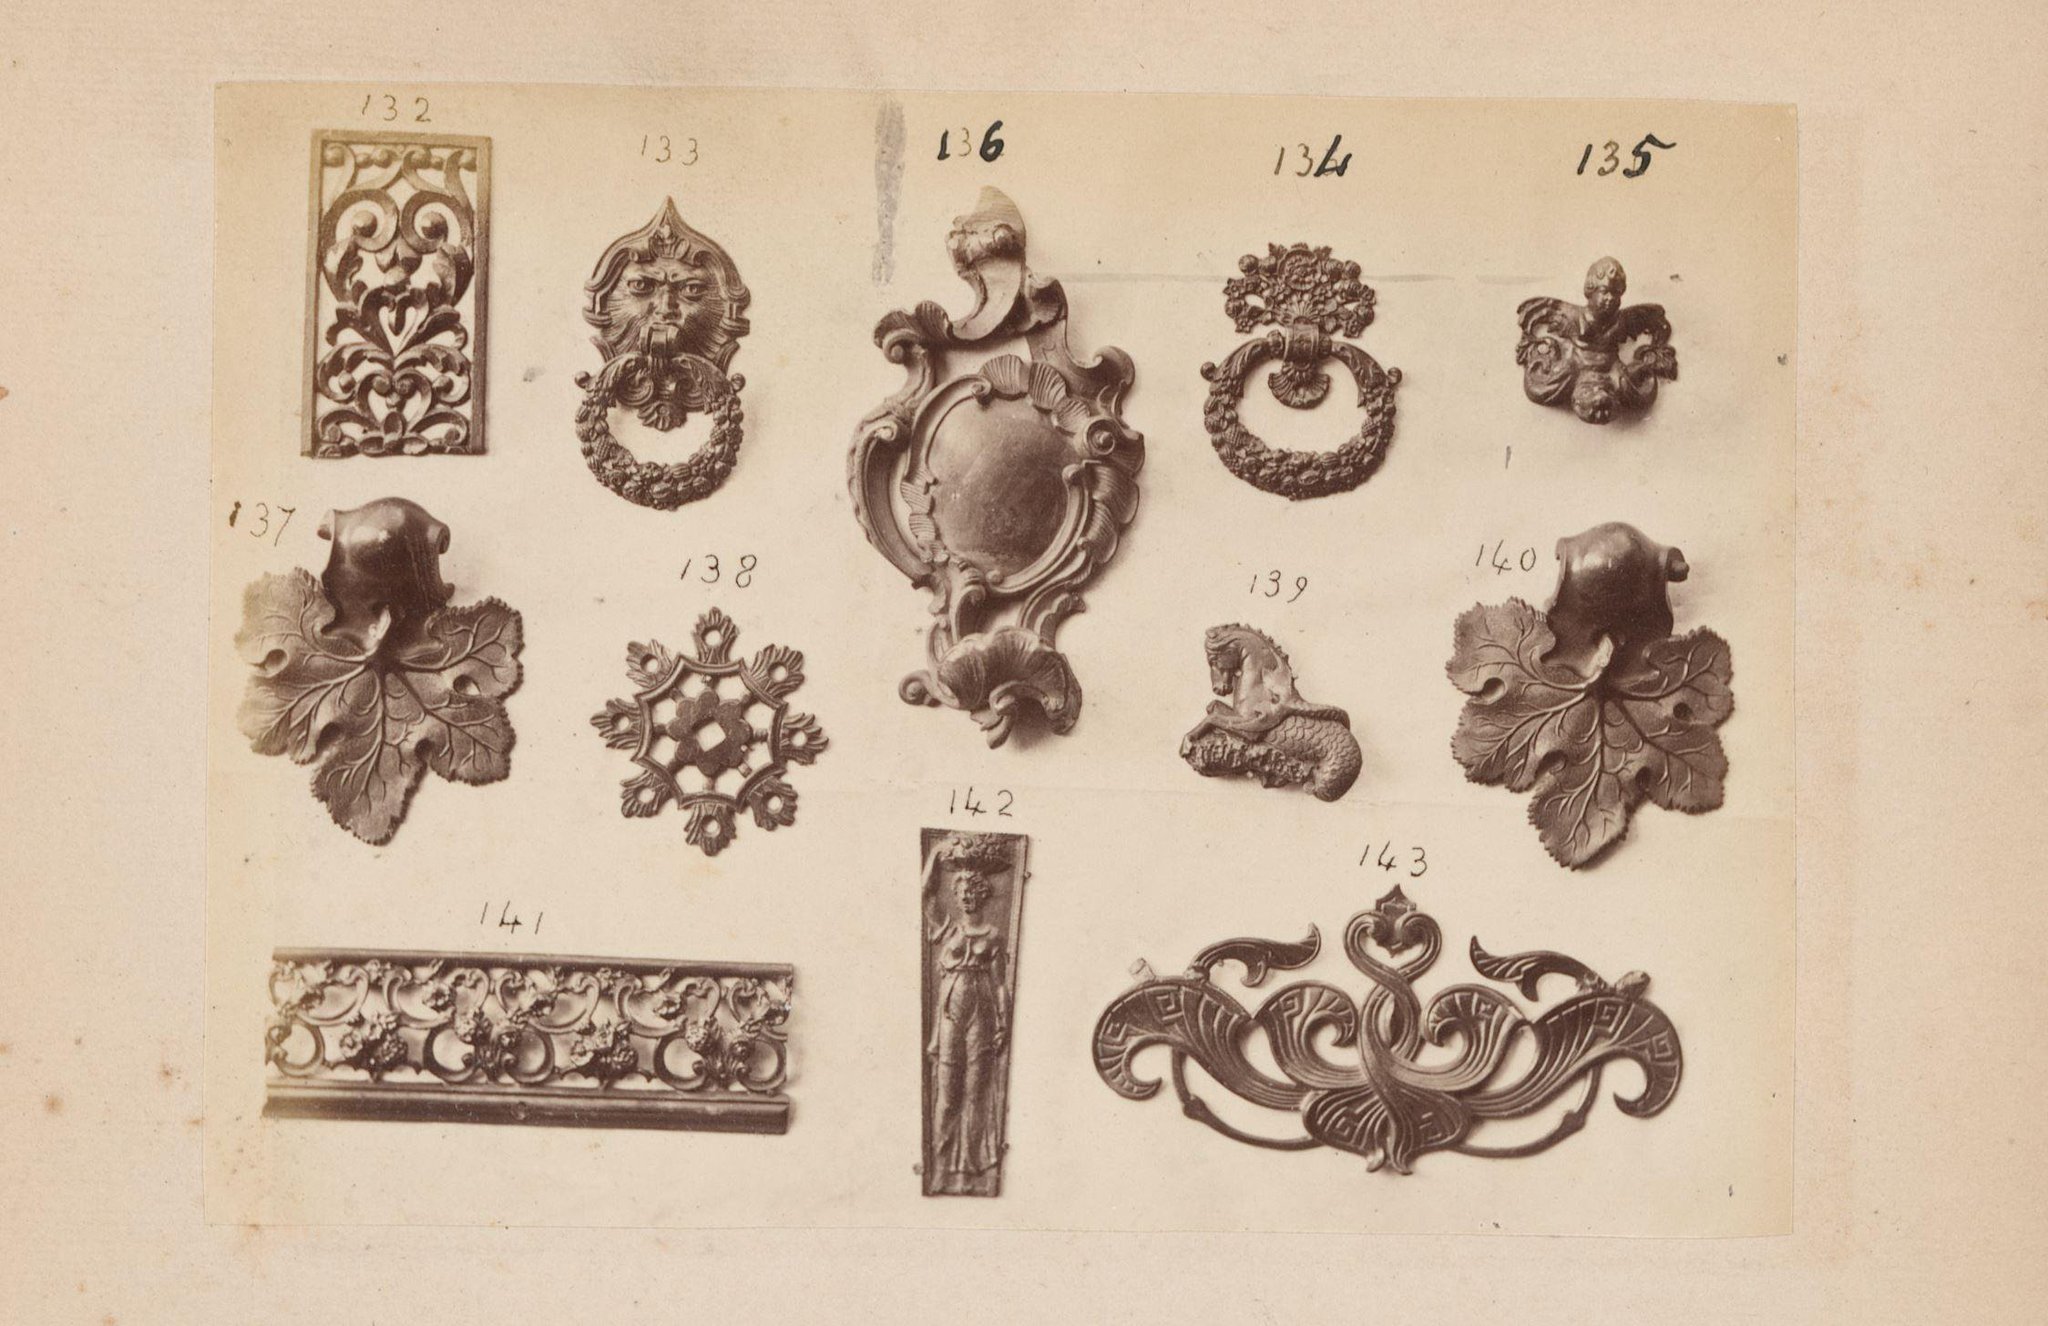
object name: page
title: Metalen randen en deurkloppers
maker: Anonymous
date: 1860-1885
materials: photographic support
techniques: albumen print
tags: door-knocker, doorbell